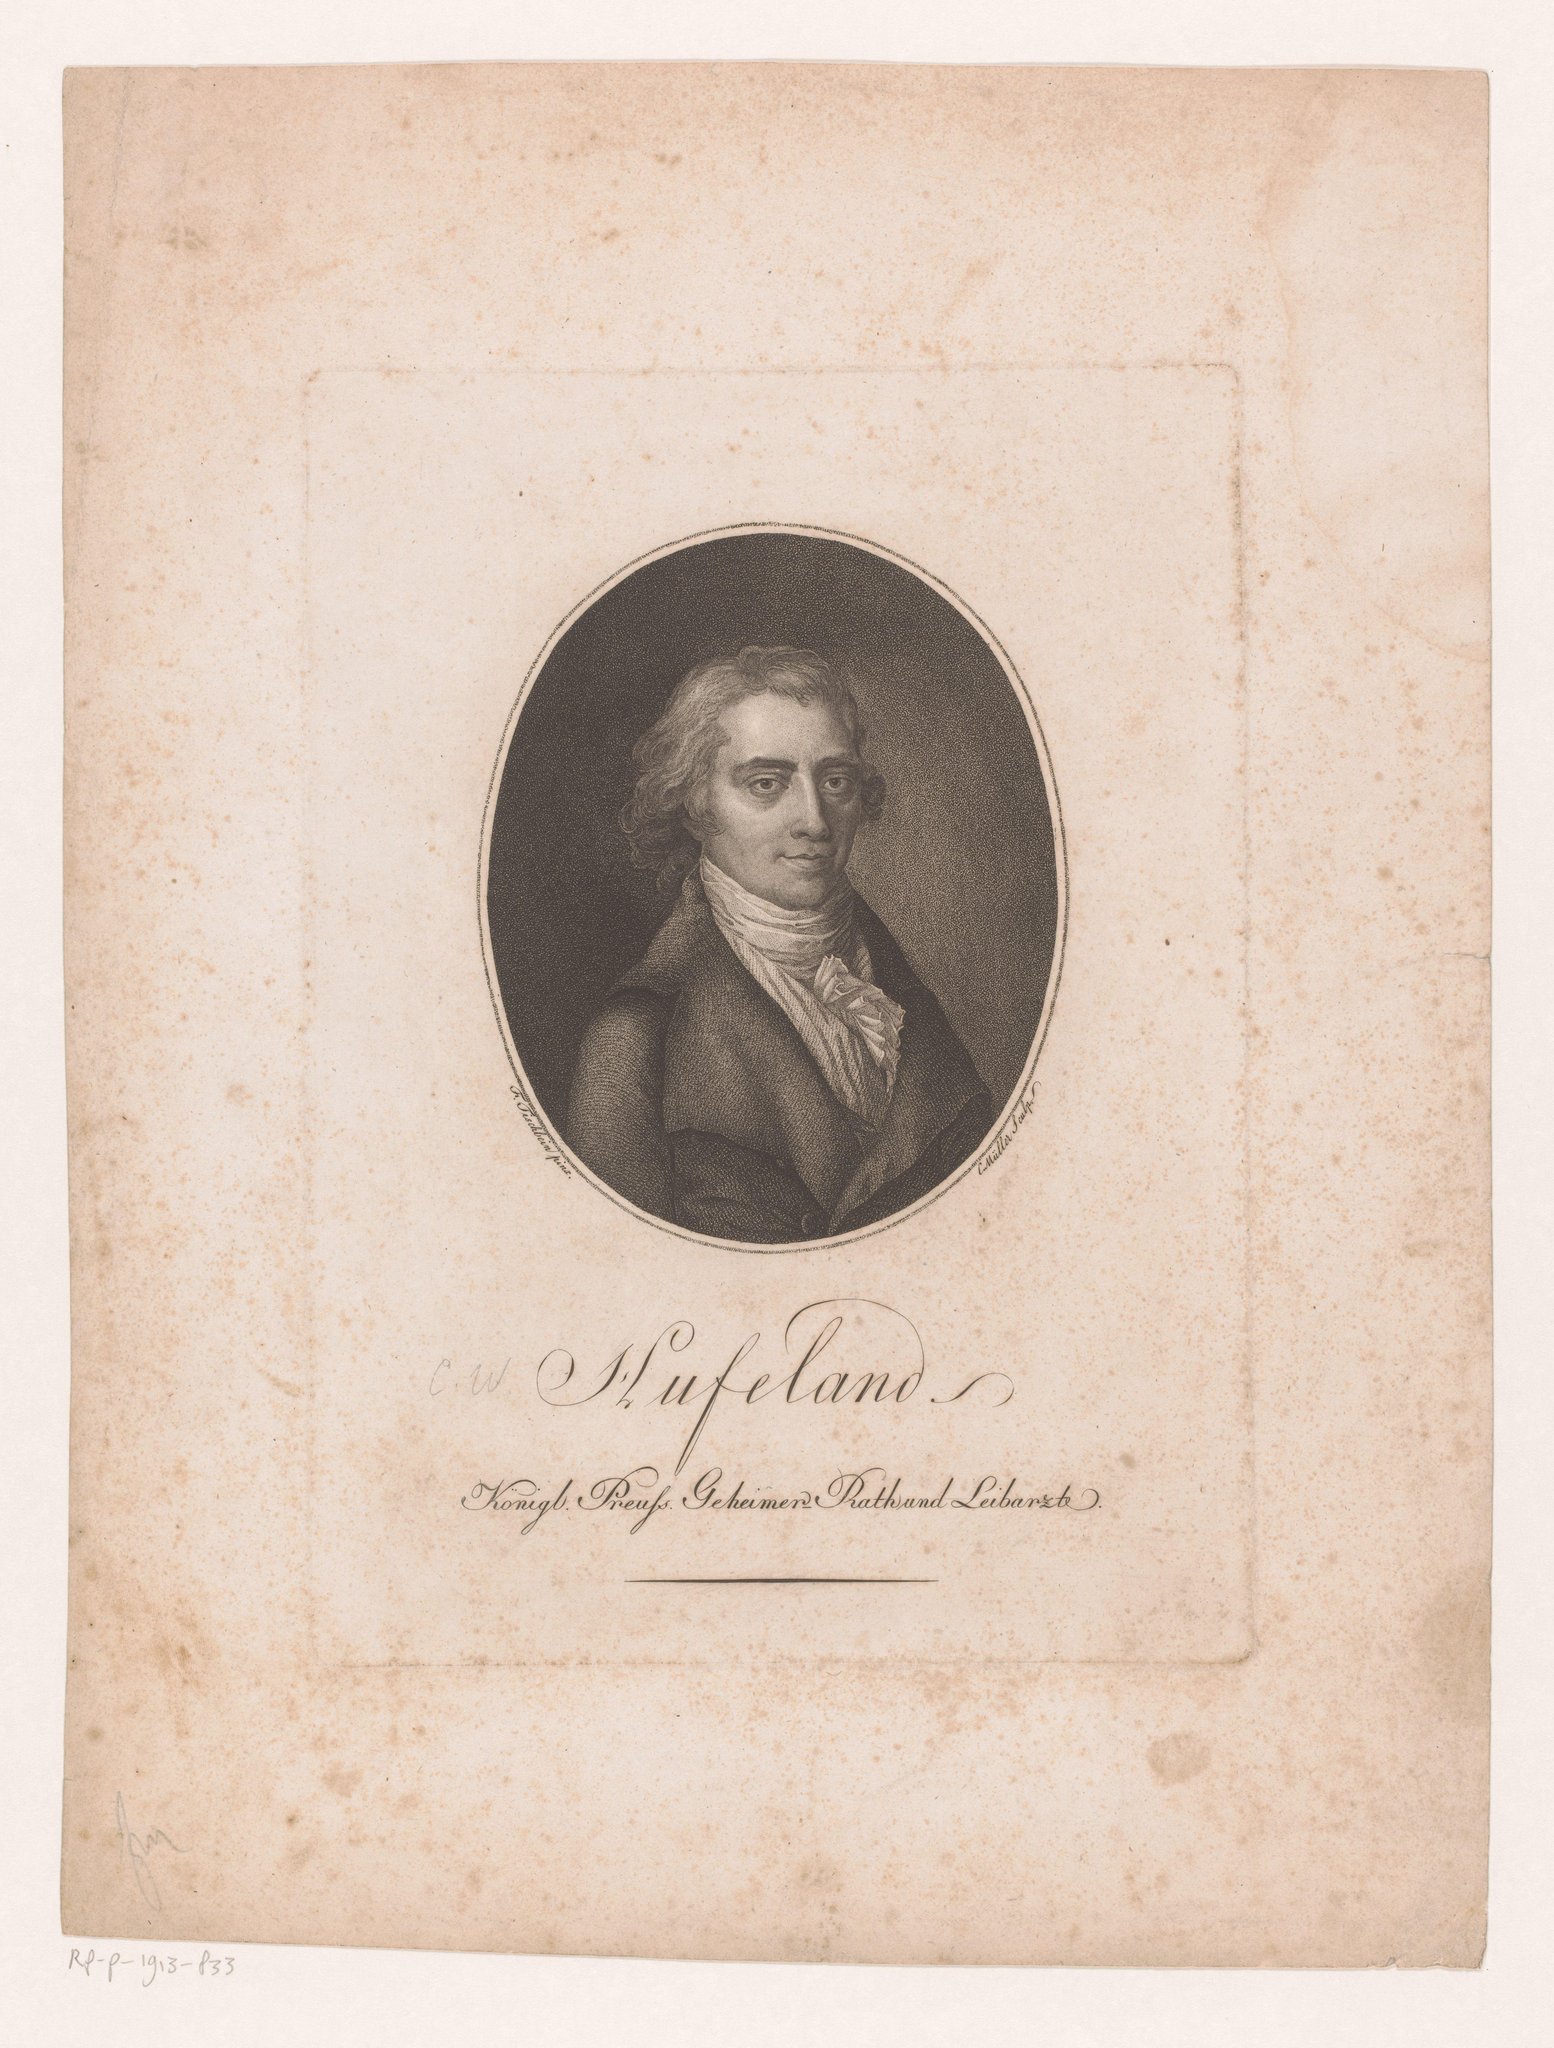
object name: print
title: Portret van Christoph Wilhelm von Hufeland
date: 1776-1824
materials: paper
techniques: engraving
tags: berlin, historical persons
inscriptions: name: ‘C.W.’, collector's mark: Lugt 2228